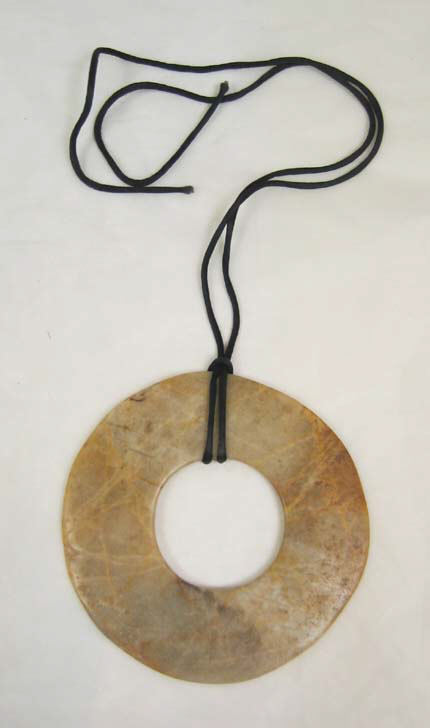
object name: pendant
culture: chinese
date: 2000-1500 BCE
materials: jade, silk